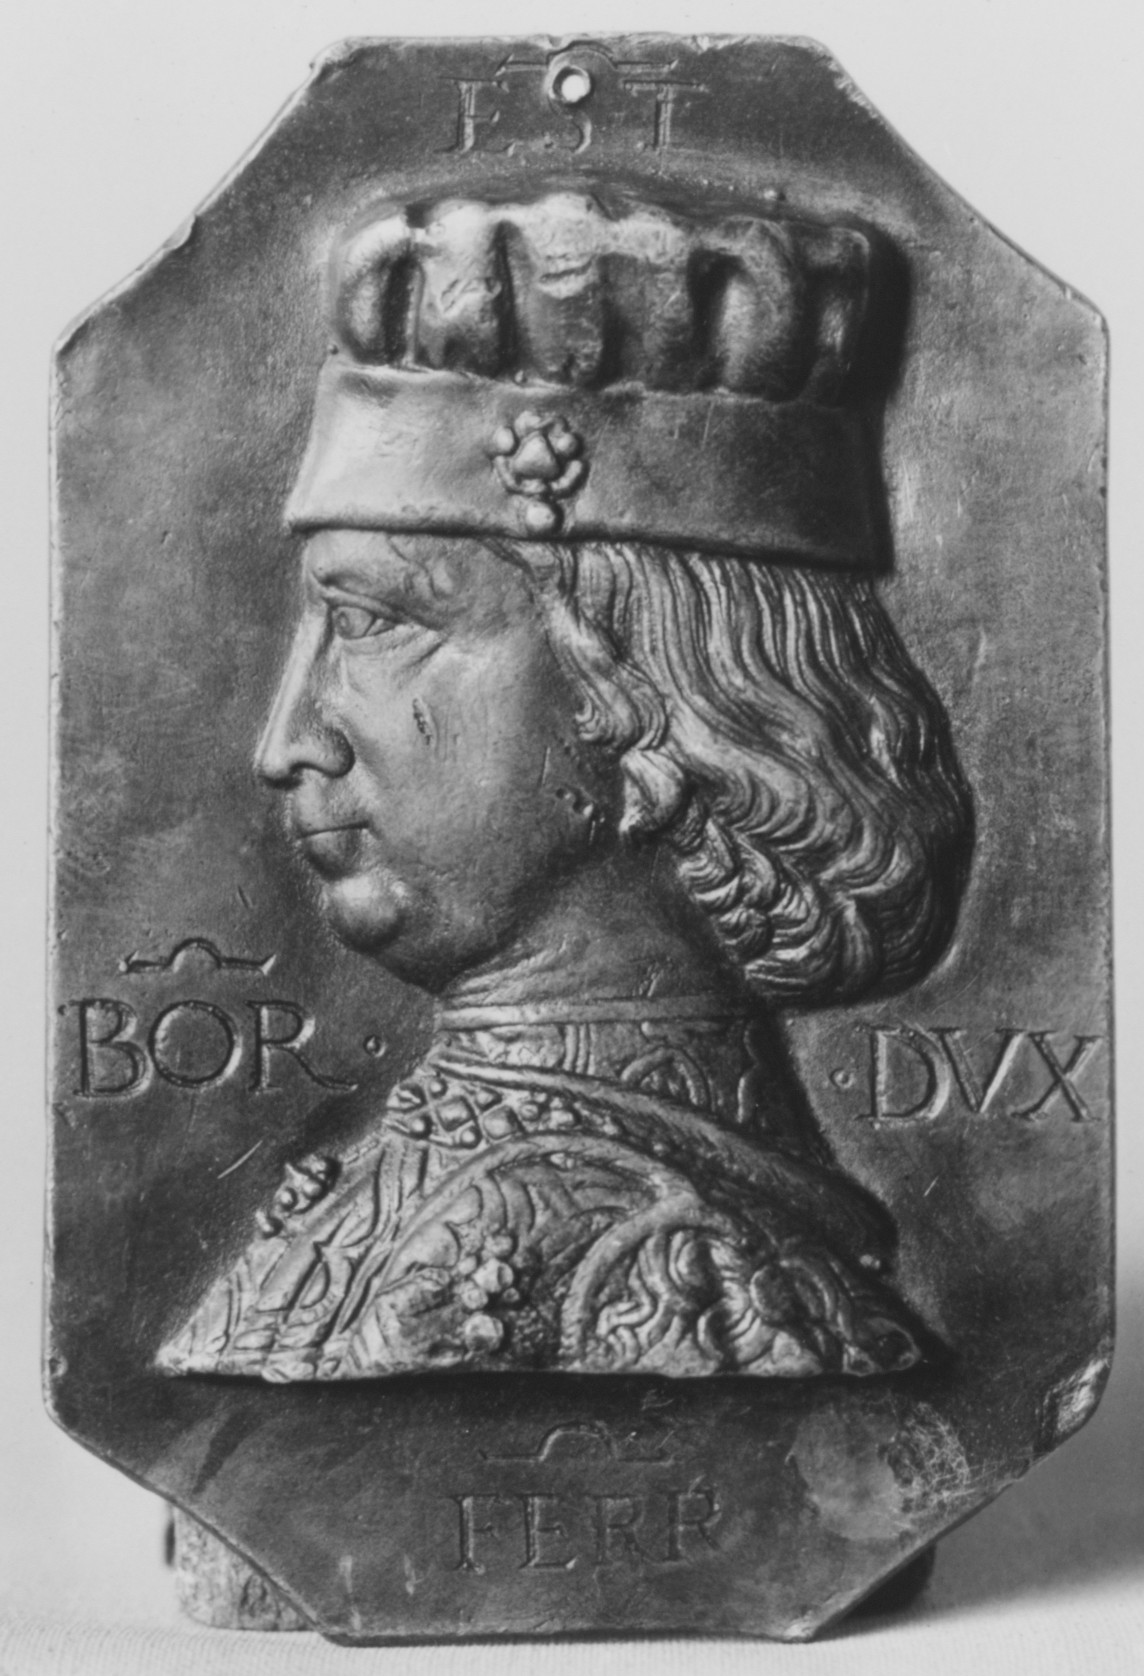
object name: medal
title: Borso d'Este, First Duke of Ferrara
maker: petrecino of florence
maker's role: artist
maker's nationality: italian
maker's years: 1450-1499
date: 1471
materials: lead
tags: men,profiles